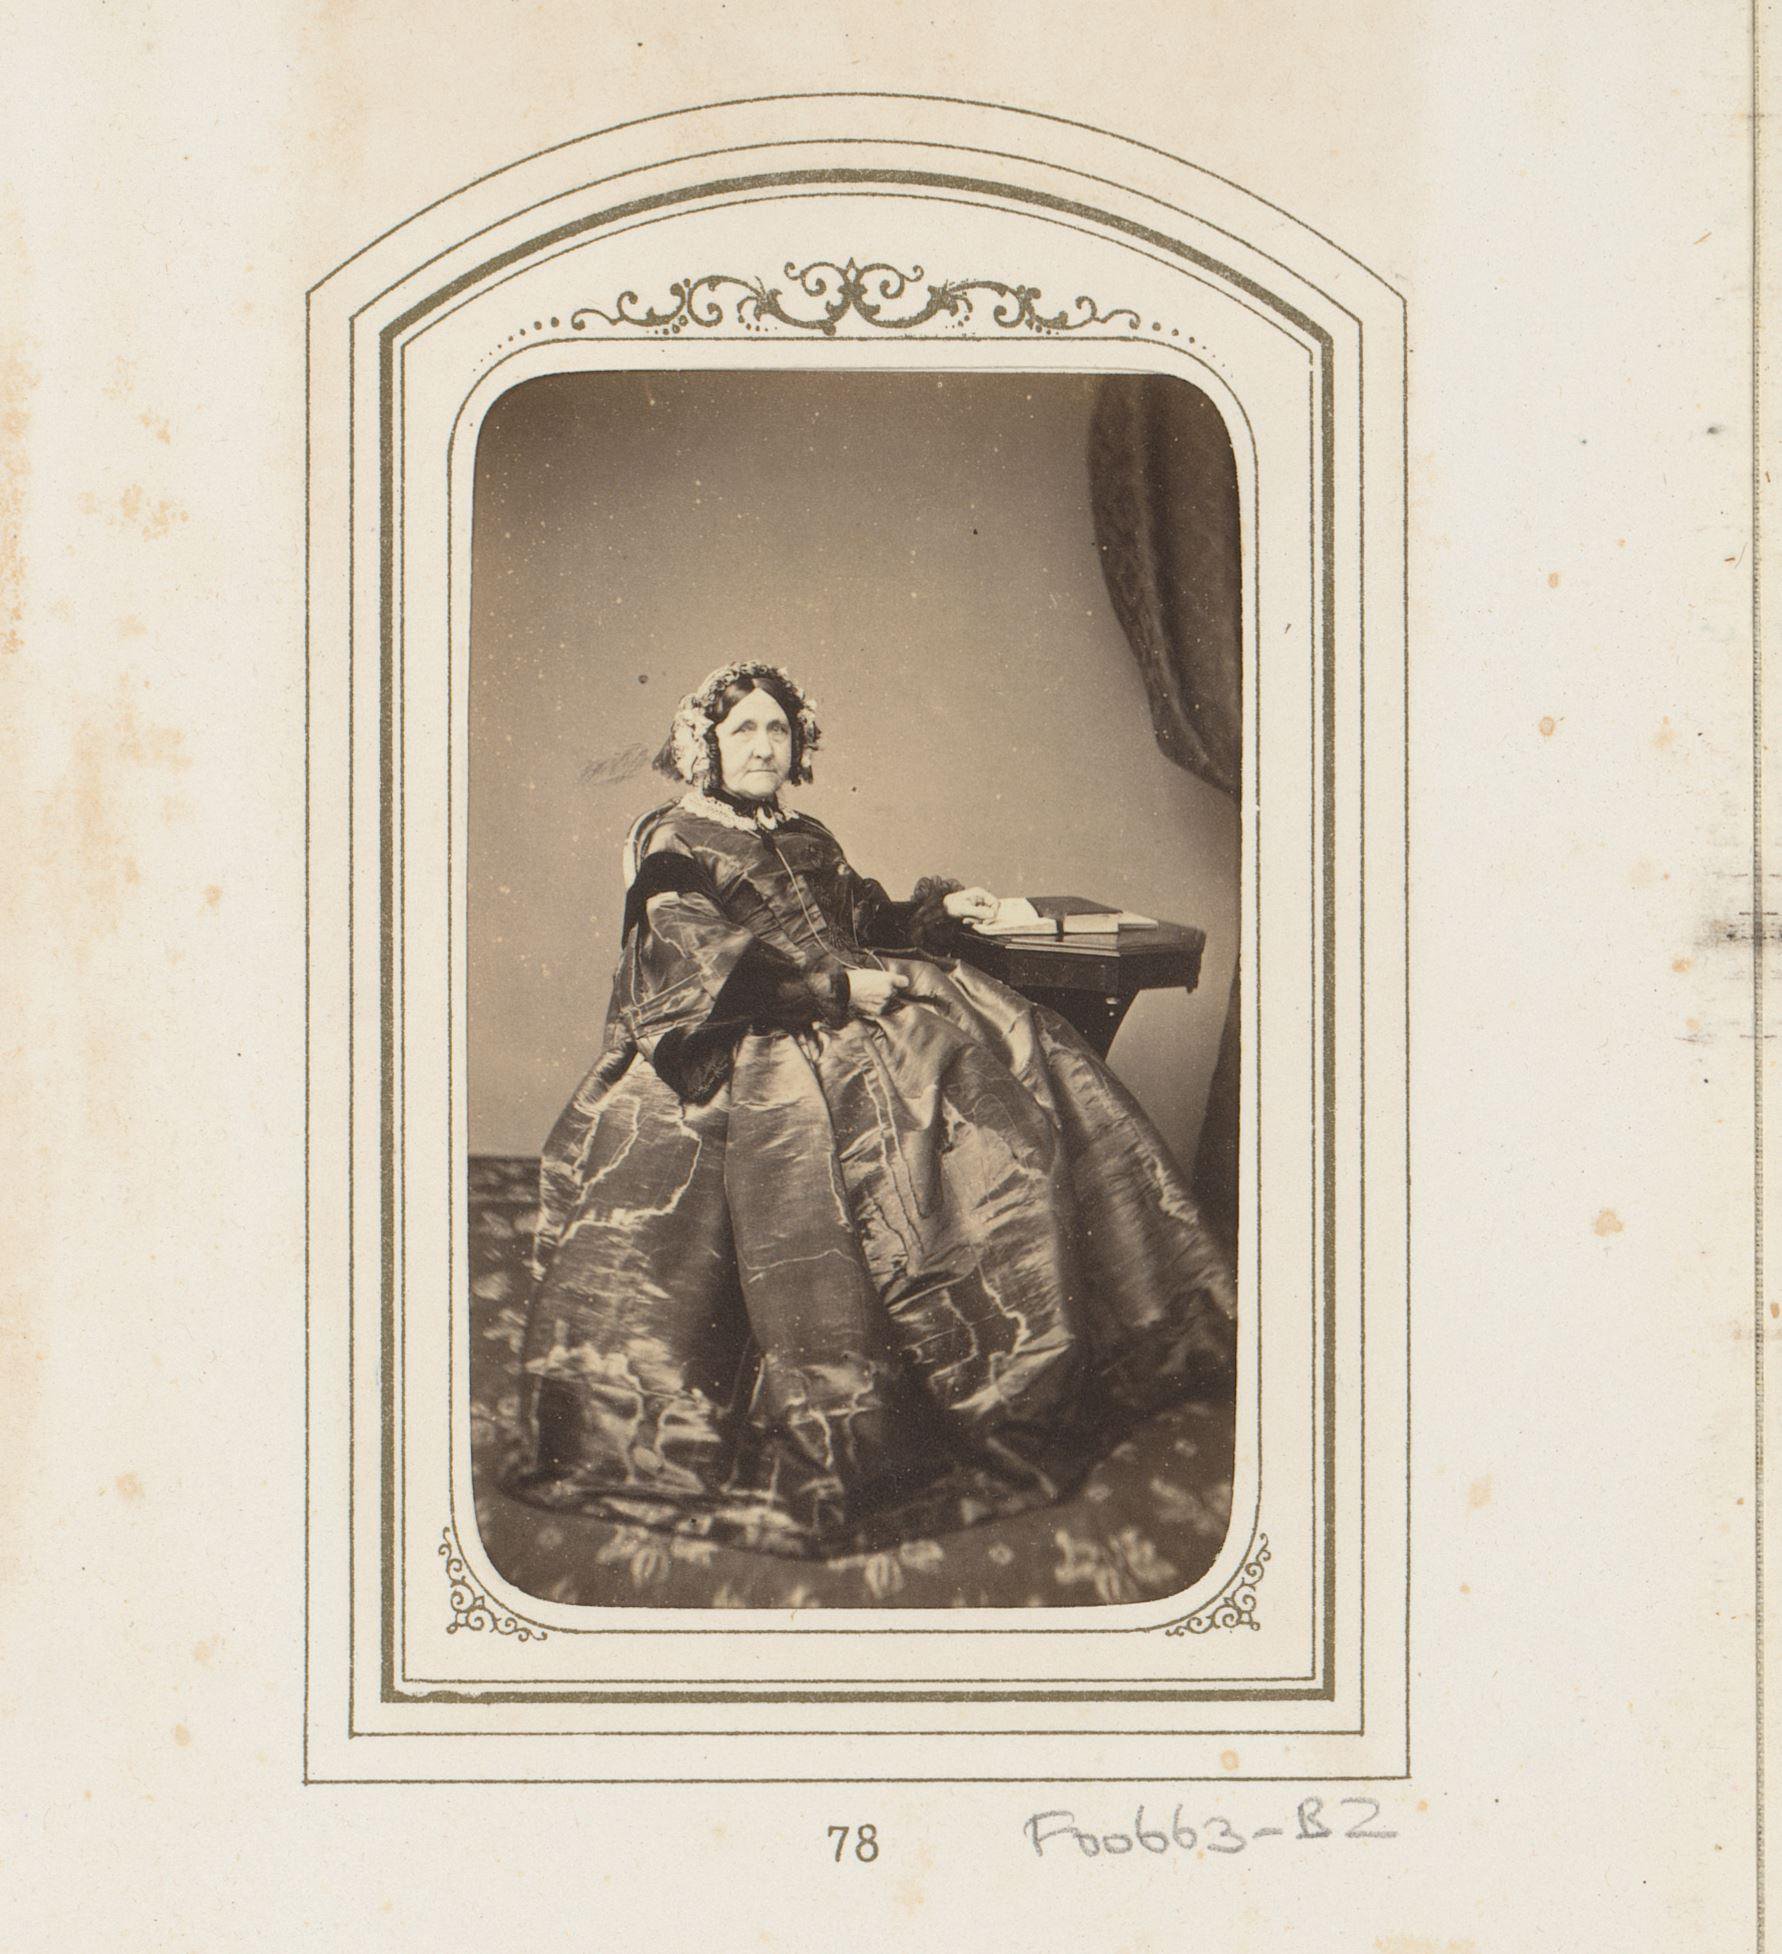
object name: photograph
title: Portret van een zittende vrouw met muts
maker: Anonymous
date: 1860-1880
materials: cardboard, photographic support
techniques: albumen print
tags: historical persons - bb - woman, head-gear: cap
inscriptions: number: ‘78’